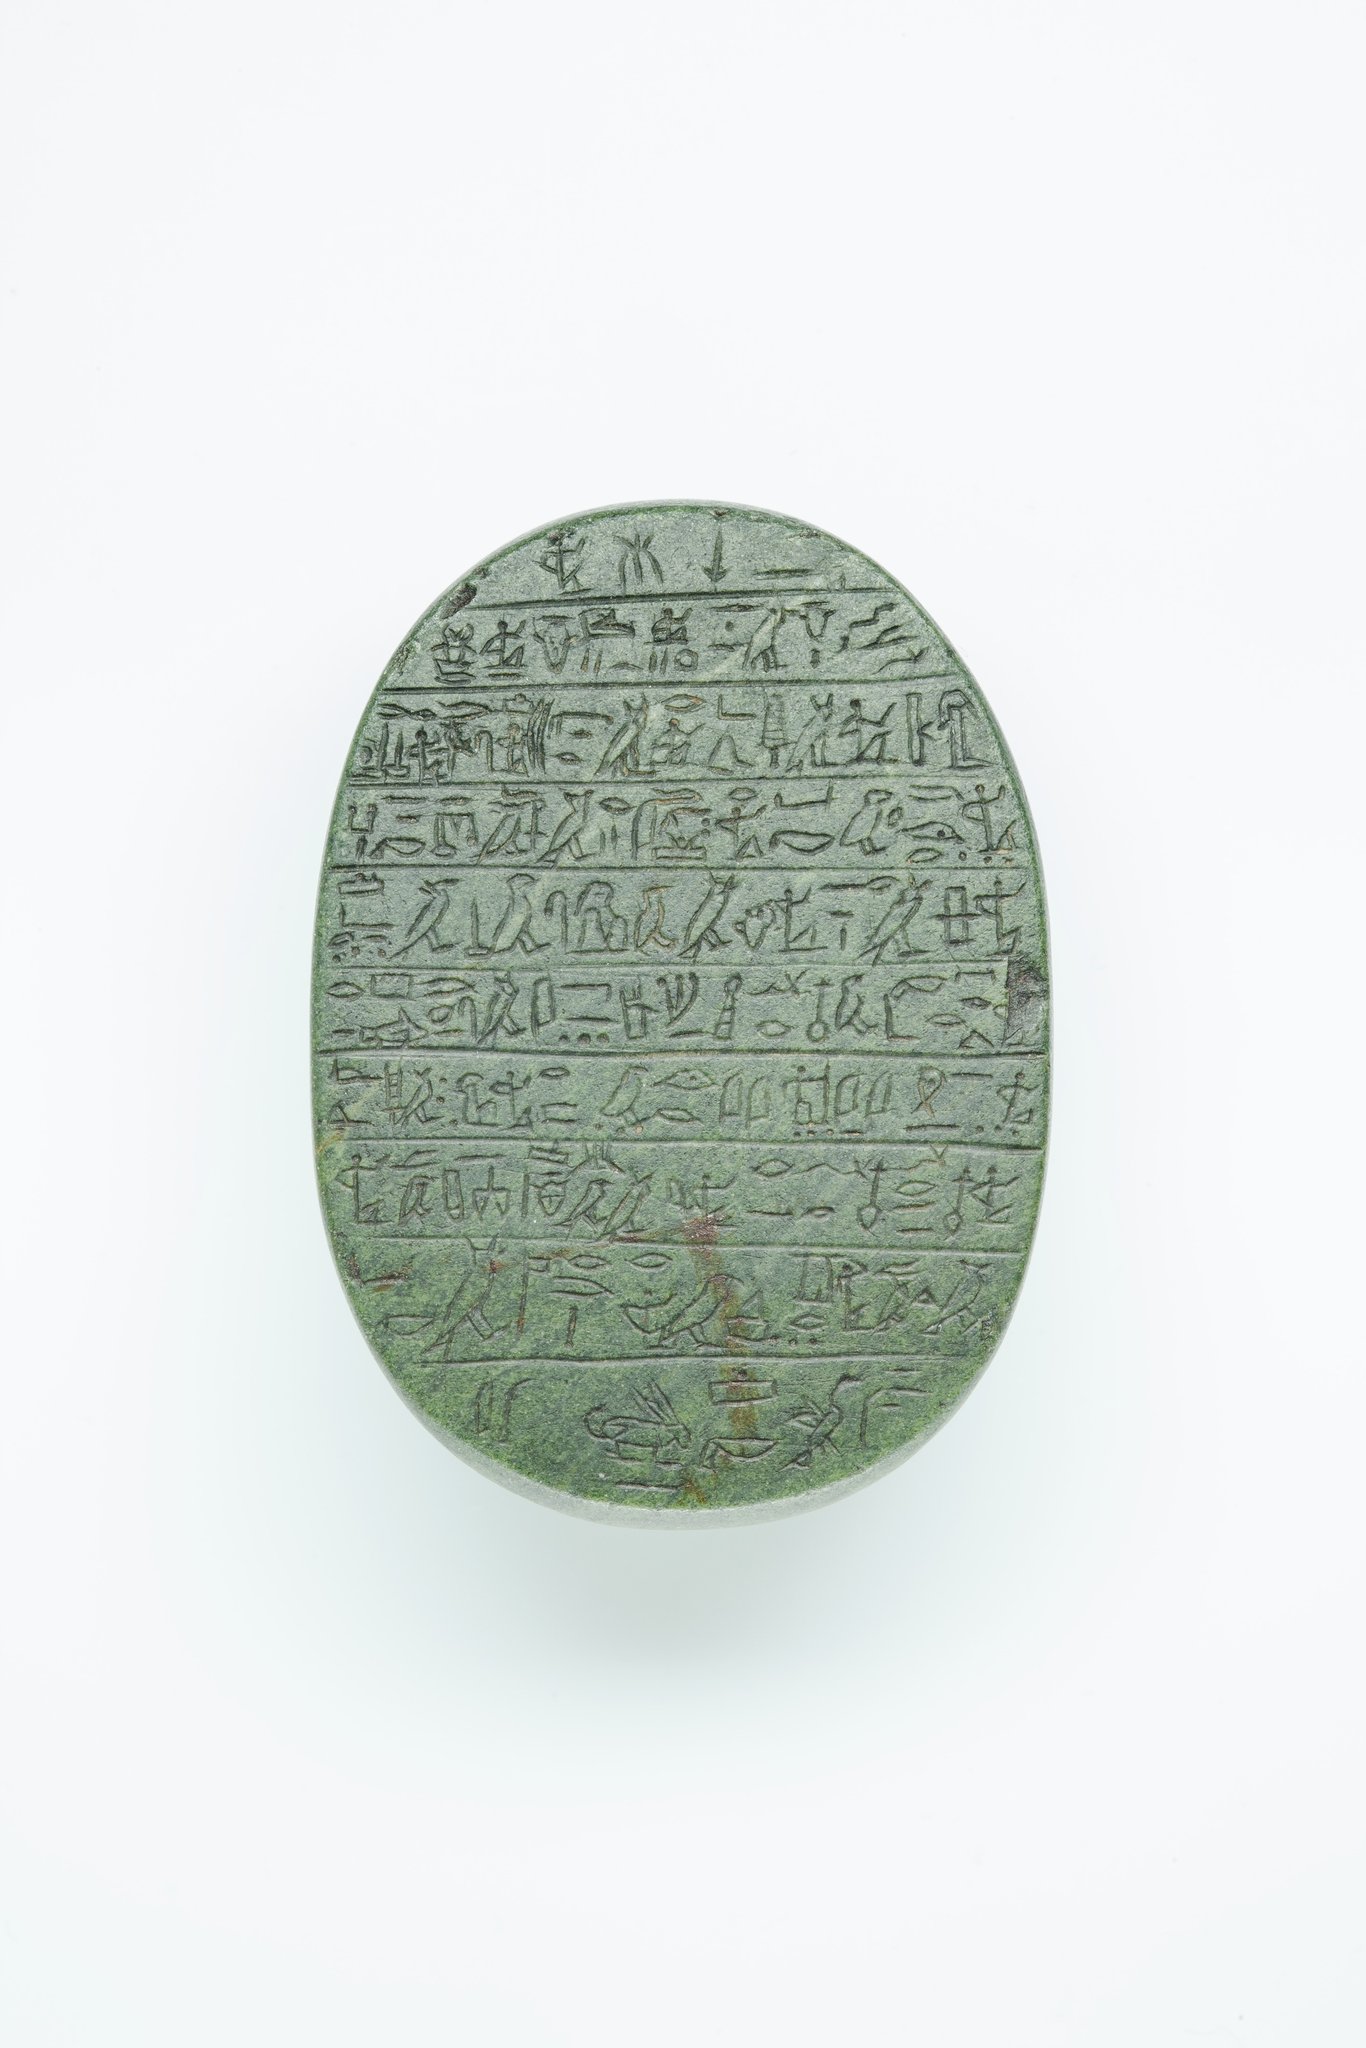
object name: heart scarab, senmes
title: Heart Scarab of Senmes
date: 1550-1295 BCE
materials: stone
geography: egypt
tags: hieroglyphs,scarabs